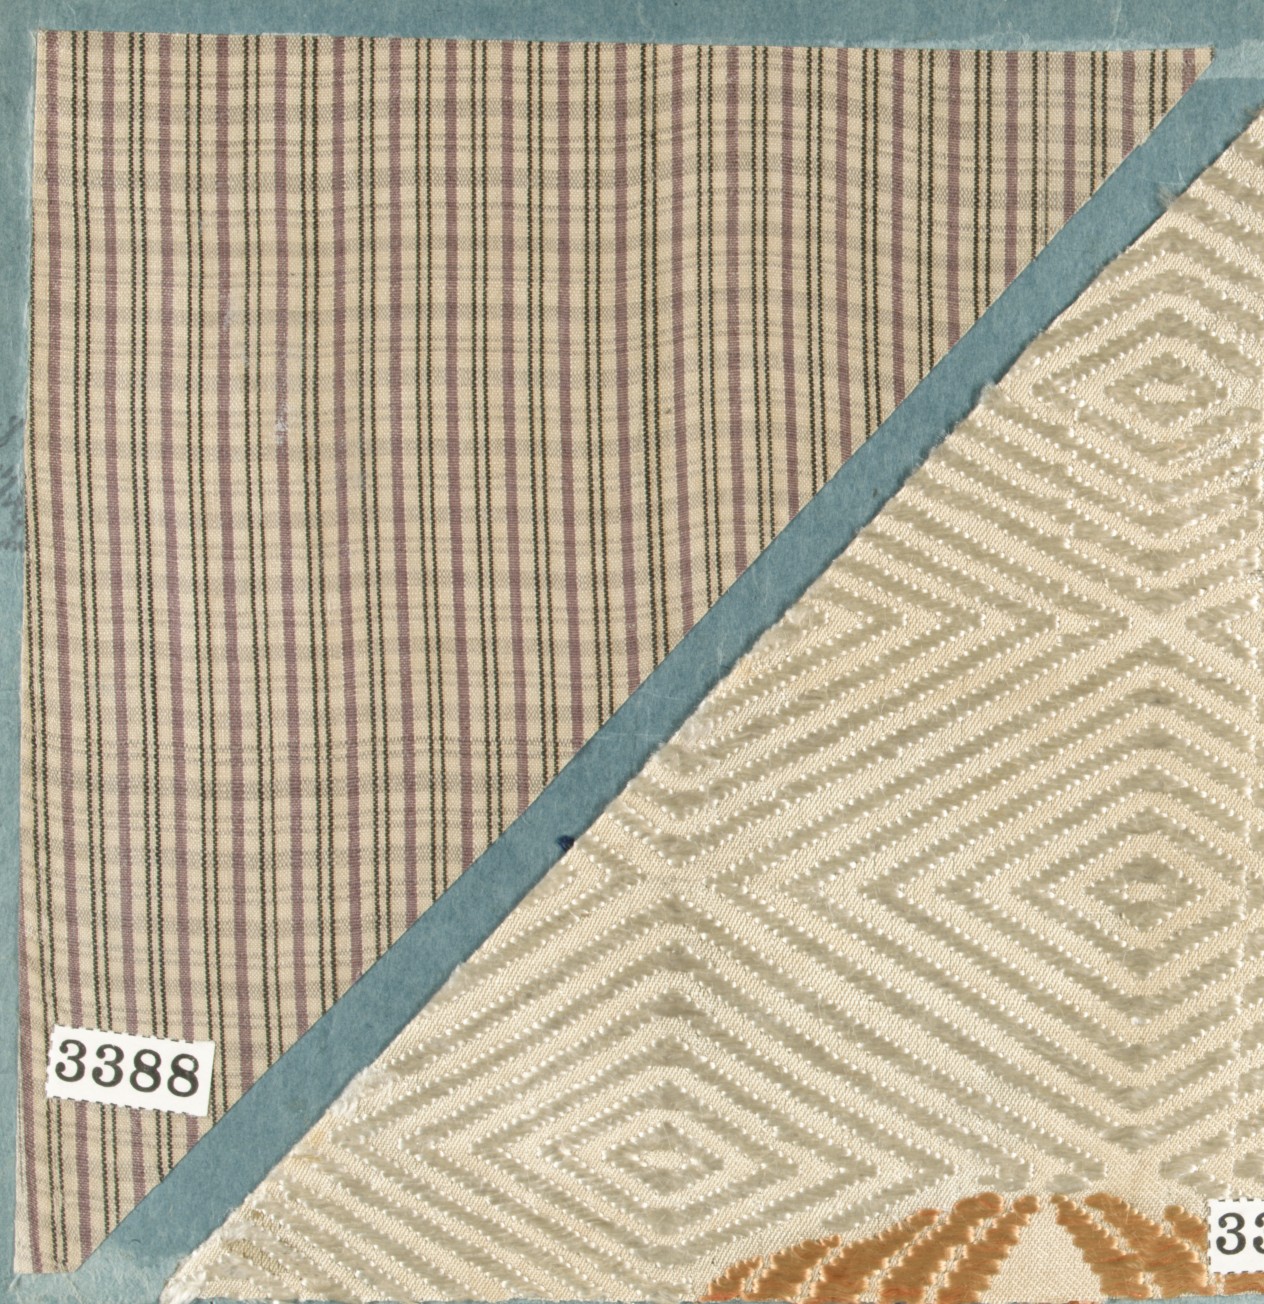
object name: textile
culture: japanese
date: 1801-1900